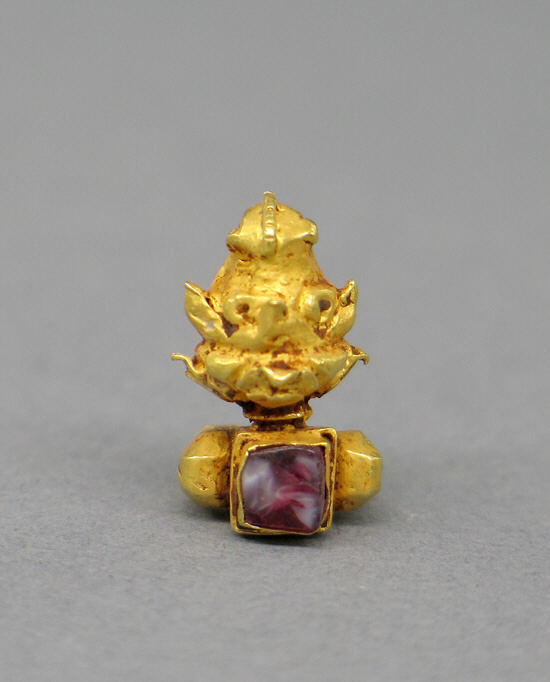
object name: ear clip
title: Pair of Ear Clips with Translucent Red Stone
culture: indonesian, javanese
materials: gold, stone